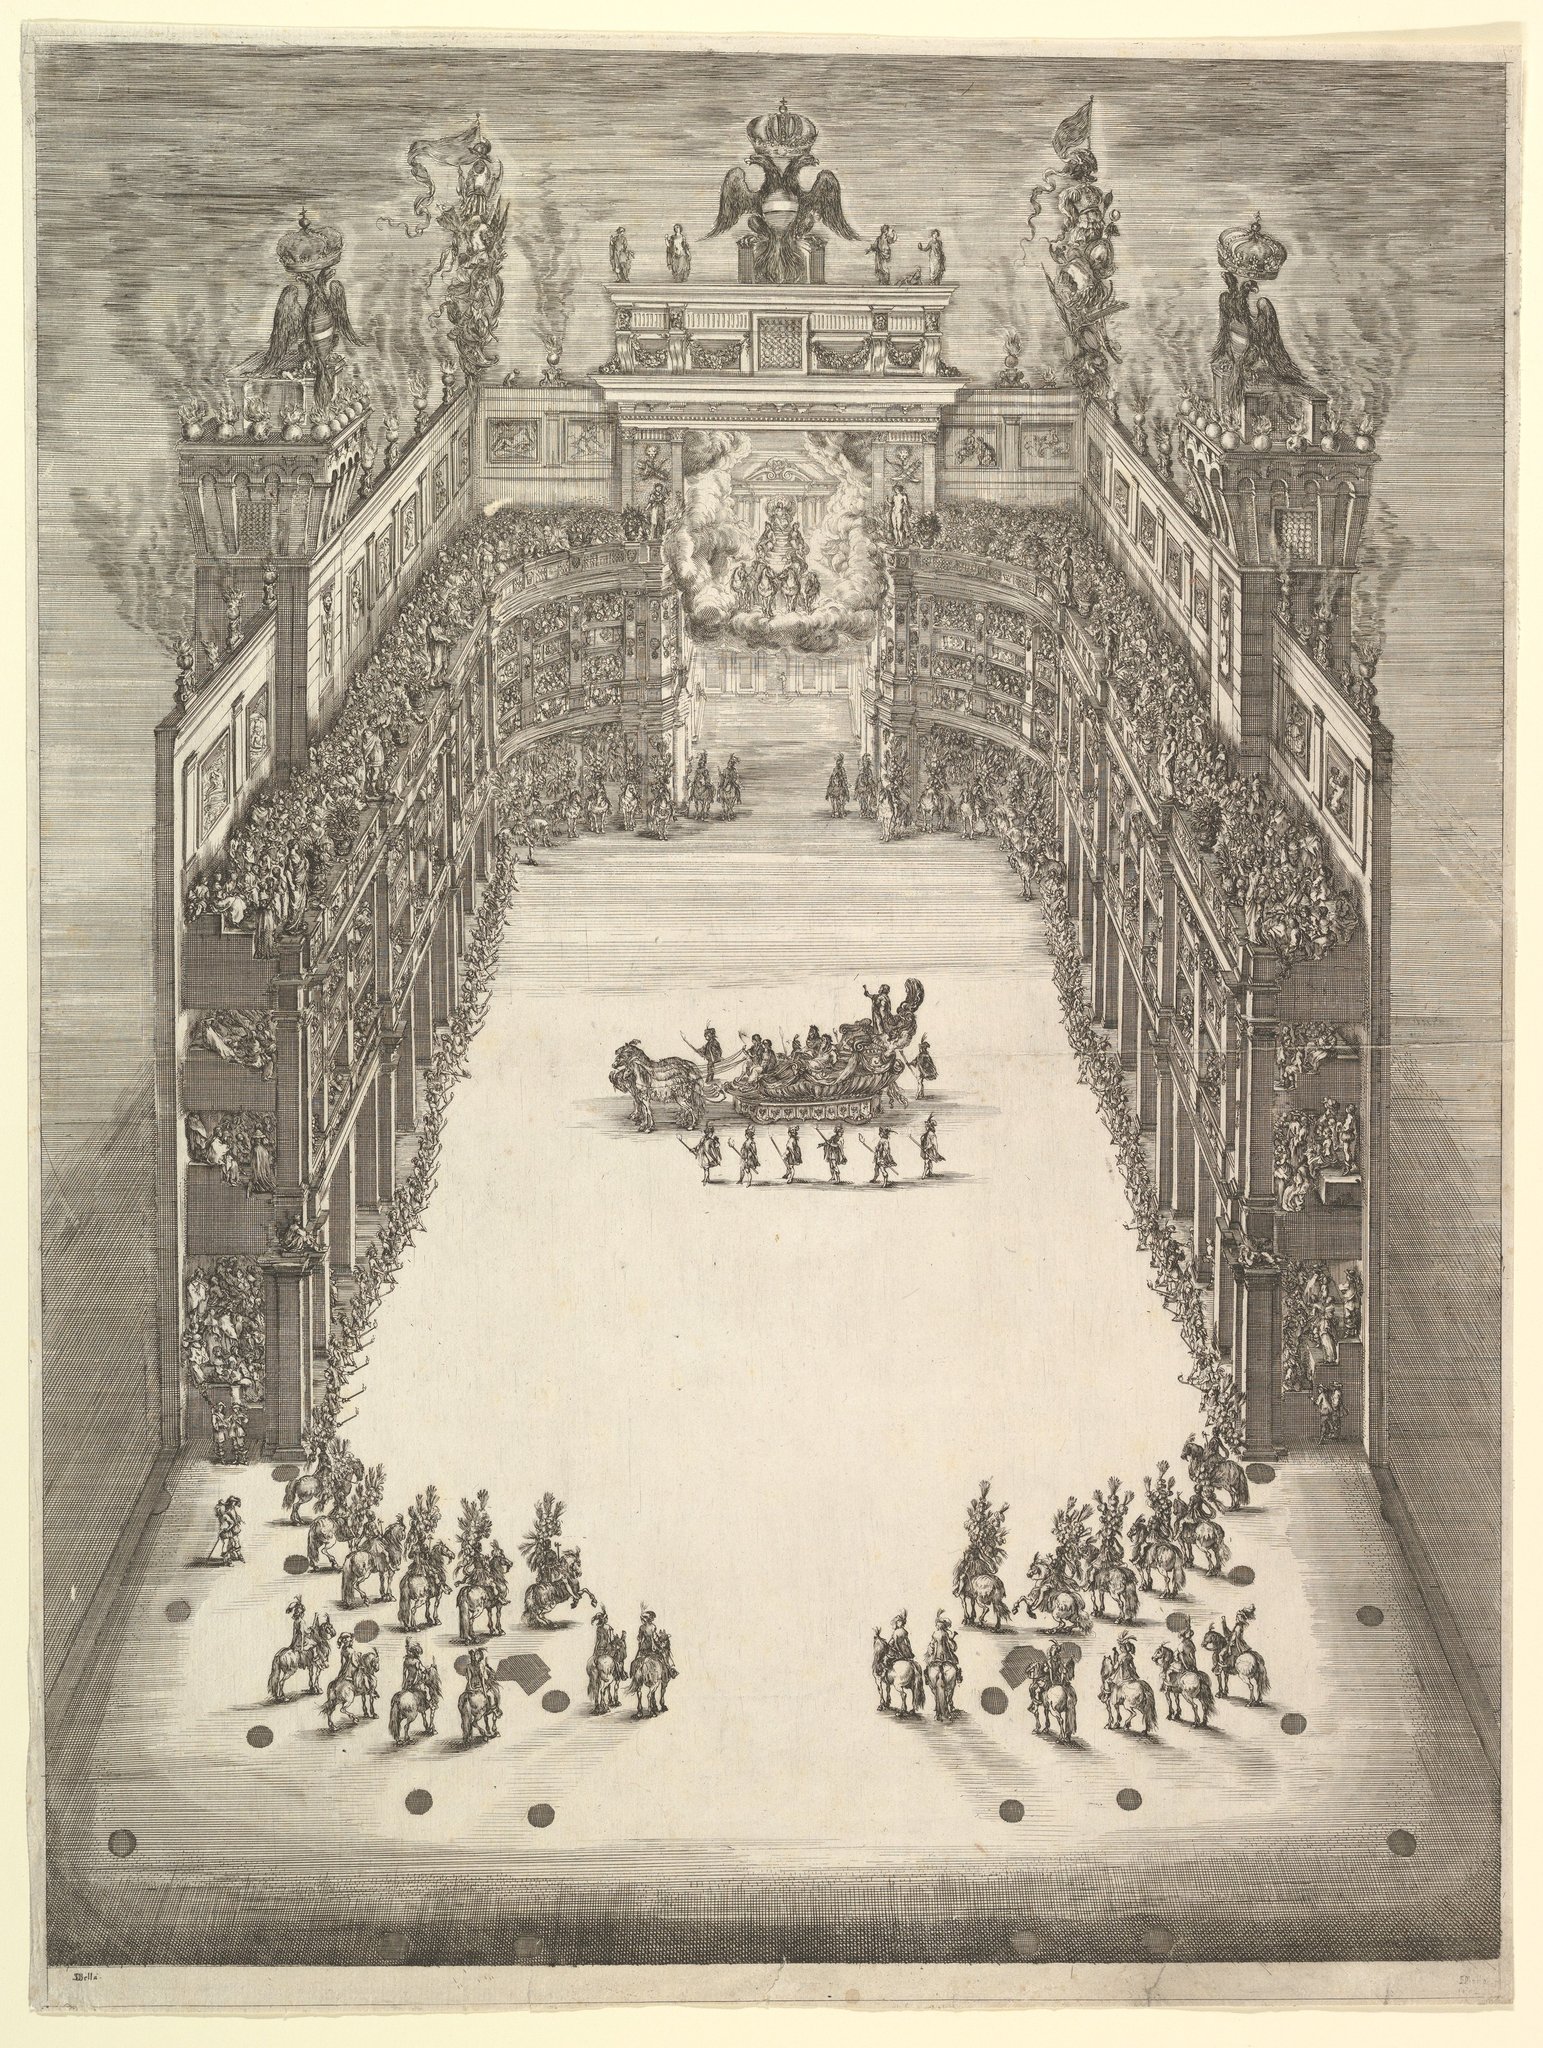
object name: print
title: Theater at Modena, seen from above and filled with spectators, with a triumphal car at center and horses in formation at lower left and right, from 'La Gara delle Stagioni'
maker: stefano della bella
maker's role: artist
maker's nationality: italian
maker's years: 1610-1664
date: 1652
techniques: etching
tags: theatre,interiors,spectators,horses,carriages